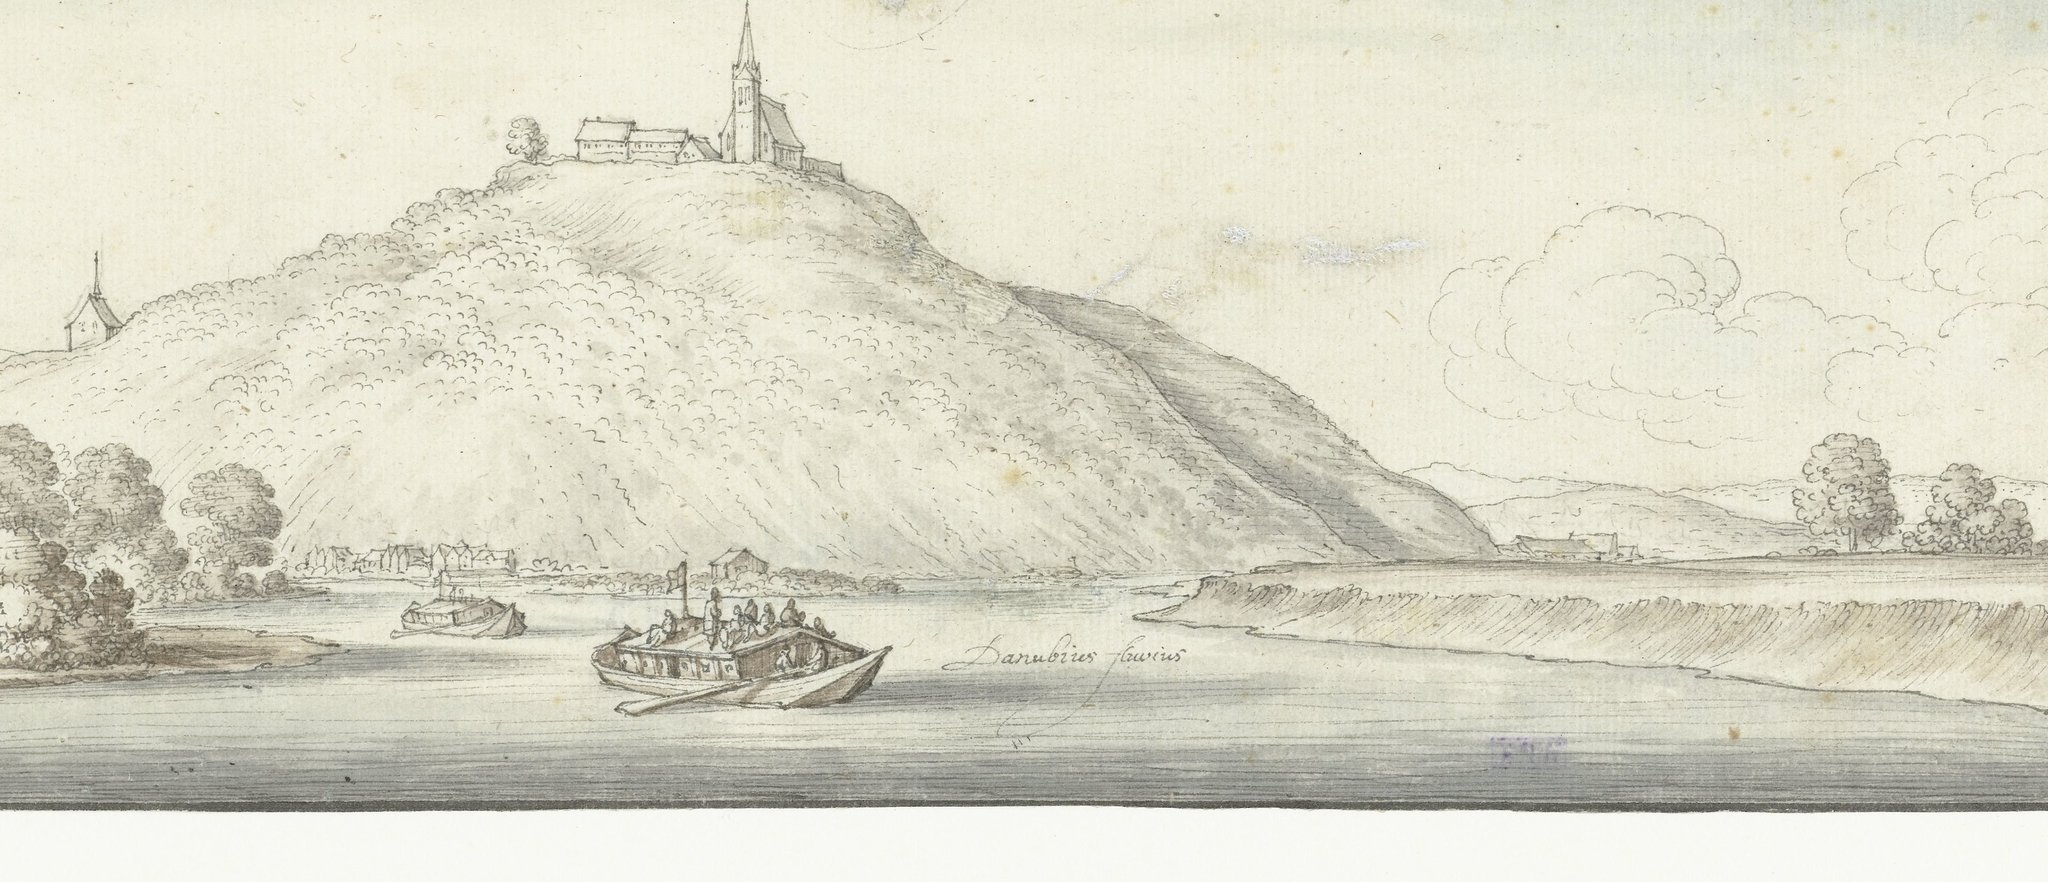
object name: drawing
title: Gezicht op de Donau bij Ober-Alteich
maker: wenceslaus hollar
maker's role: draughtsman, print maker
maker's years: 1607-1677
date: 1625-1650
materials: ink, paper, pencil, watercolor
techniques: brush, pen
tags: river (+ landscape with figures, staffage)